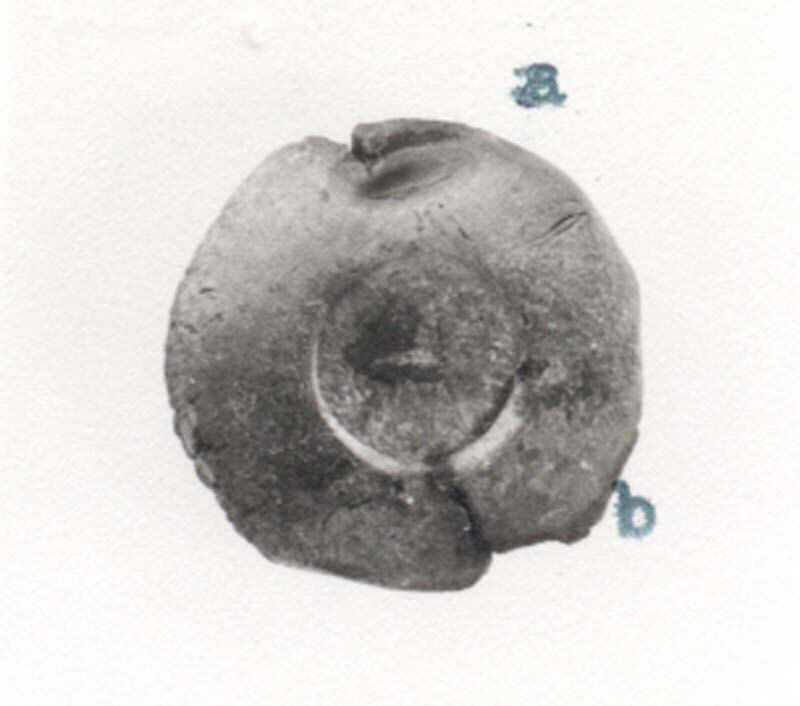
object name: sealing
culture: sasanian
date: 601-700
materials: clay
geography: iran